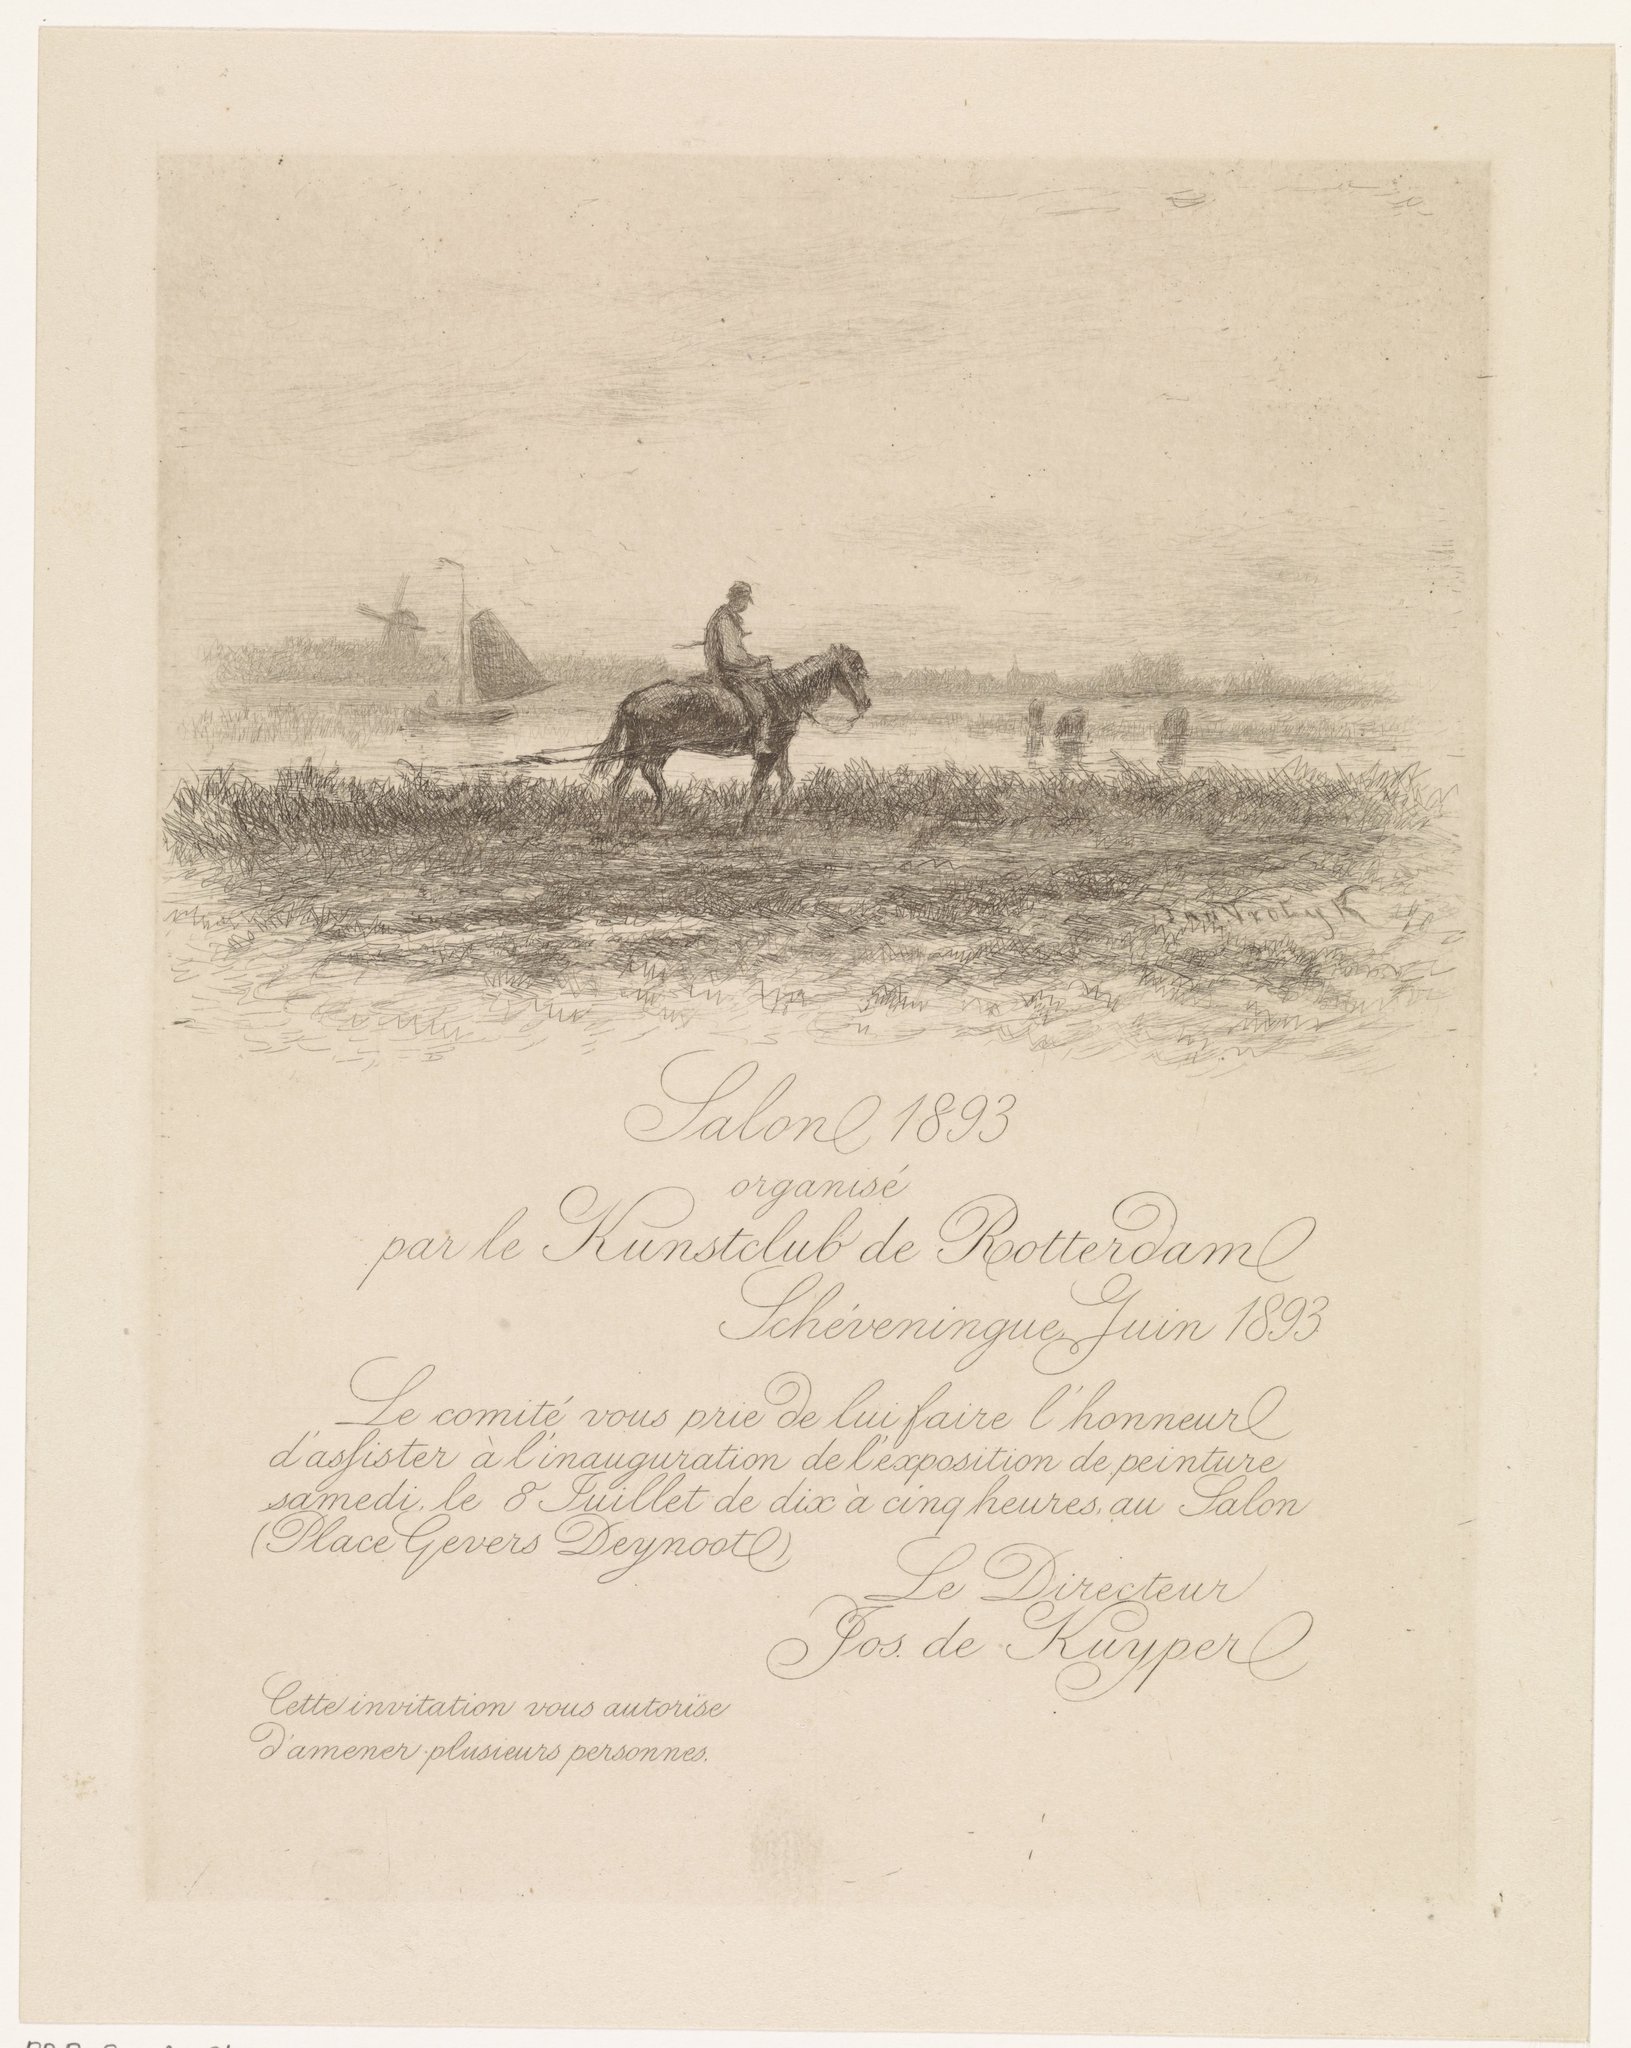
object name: invitation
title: Uitnodiging tot het bijwonen van een tentoonstelling van de Rotterdamsche Kunstclub, 1893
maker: jan vrolijk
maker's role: draughtsman, painter, print maker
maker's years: 1846-1894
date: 1893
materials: paper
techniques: etching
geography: the hague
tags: riding a horse, ass, or mule; rider, horseman, windmill in landscape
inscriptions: collector's mark: Lugt 2228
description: Uitnodiging tot het bijwonen van een tentoonstelling van de Rotterdamsche Kunstclub in het gebouw van de Rotterdamsche Kunstclub aan het Gevers Deynootplein. Bovenaan een gezicht op een Hollandse trekvaart. Op de oever een jaagpaard waarop een schuitejager. Onder de voorstelling een achtregelige tekst in het Frans.